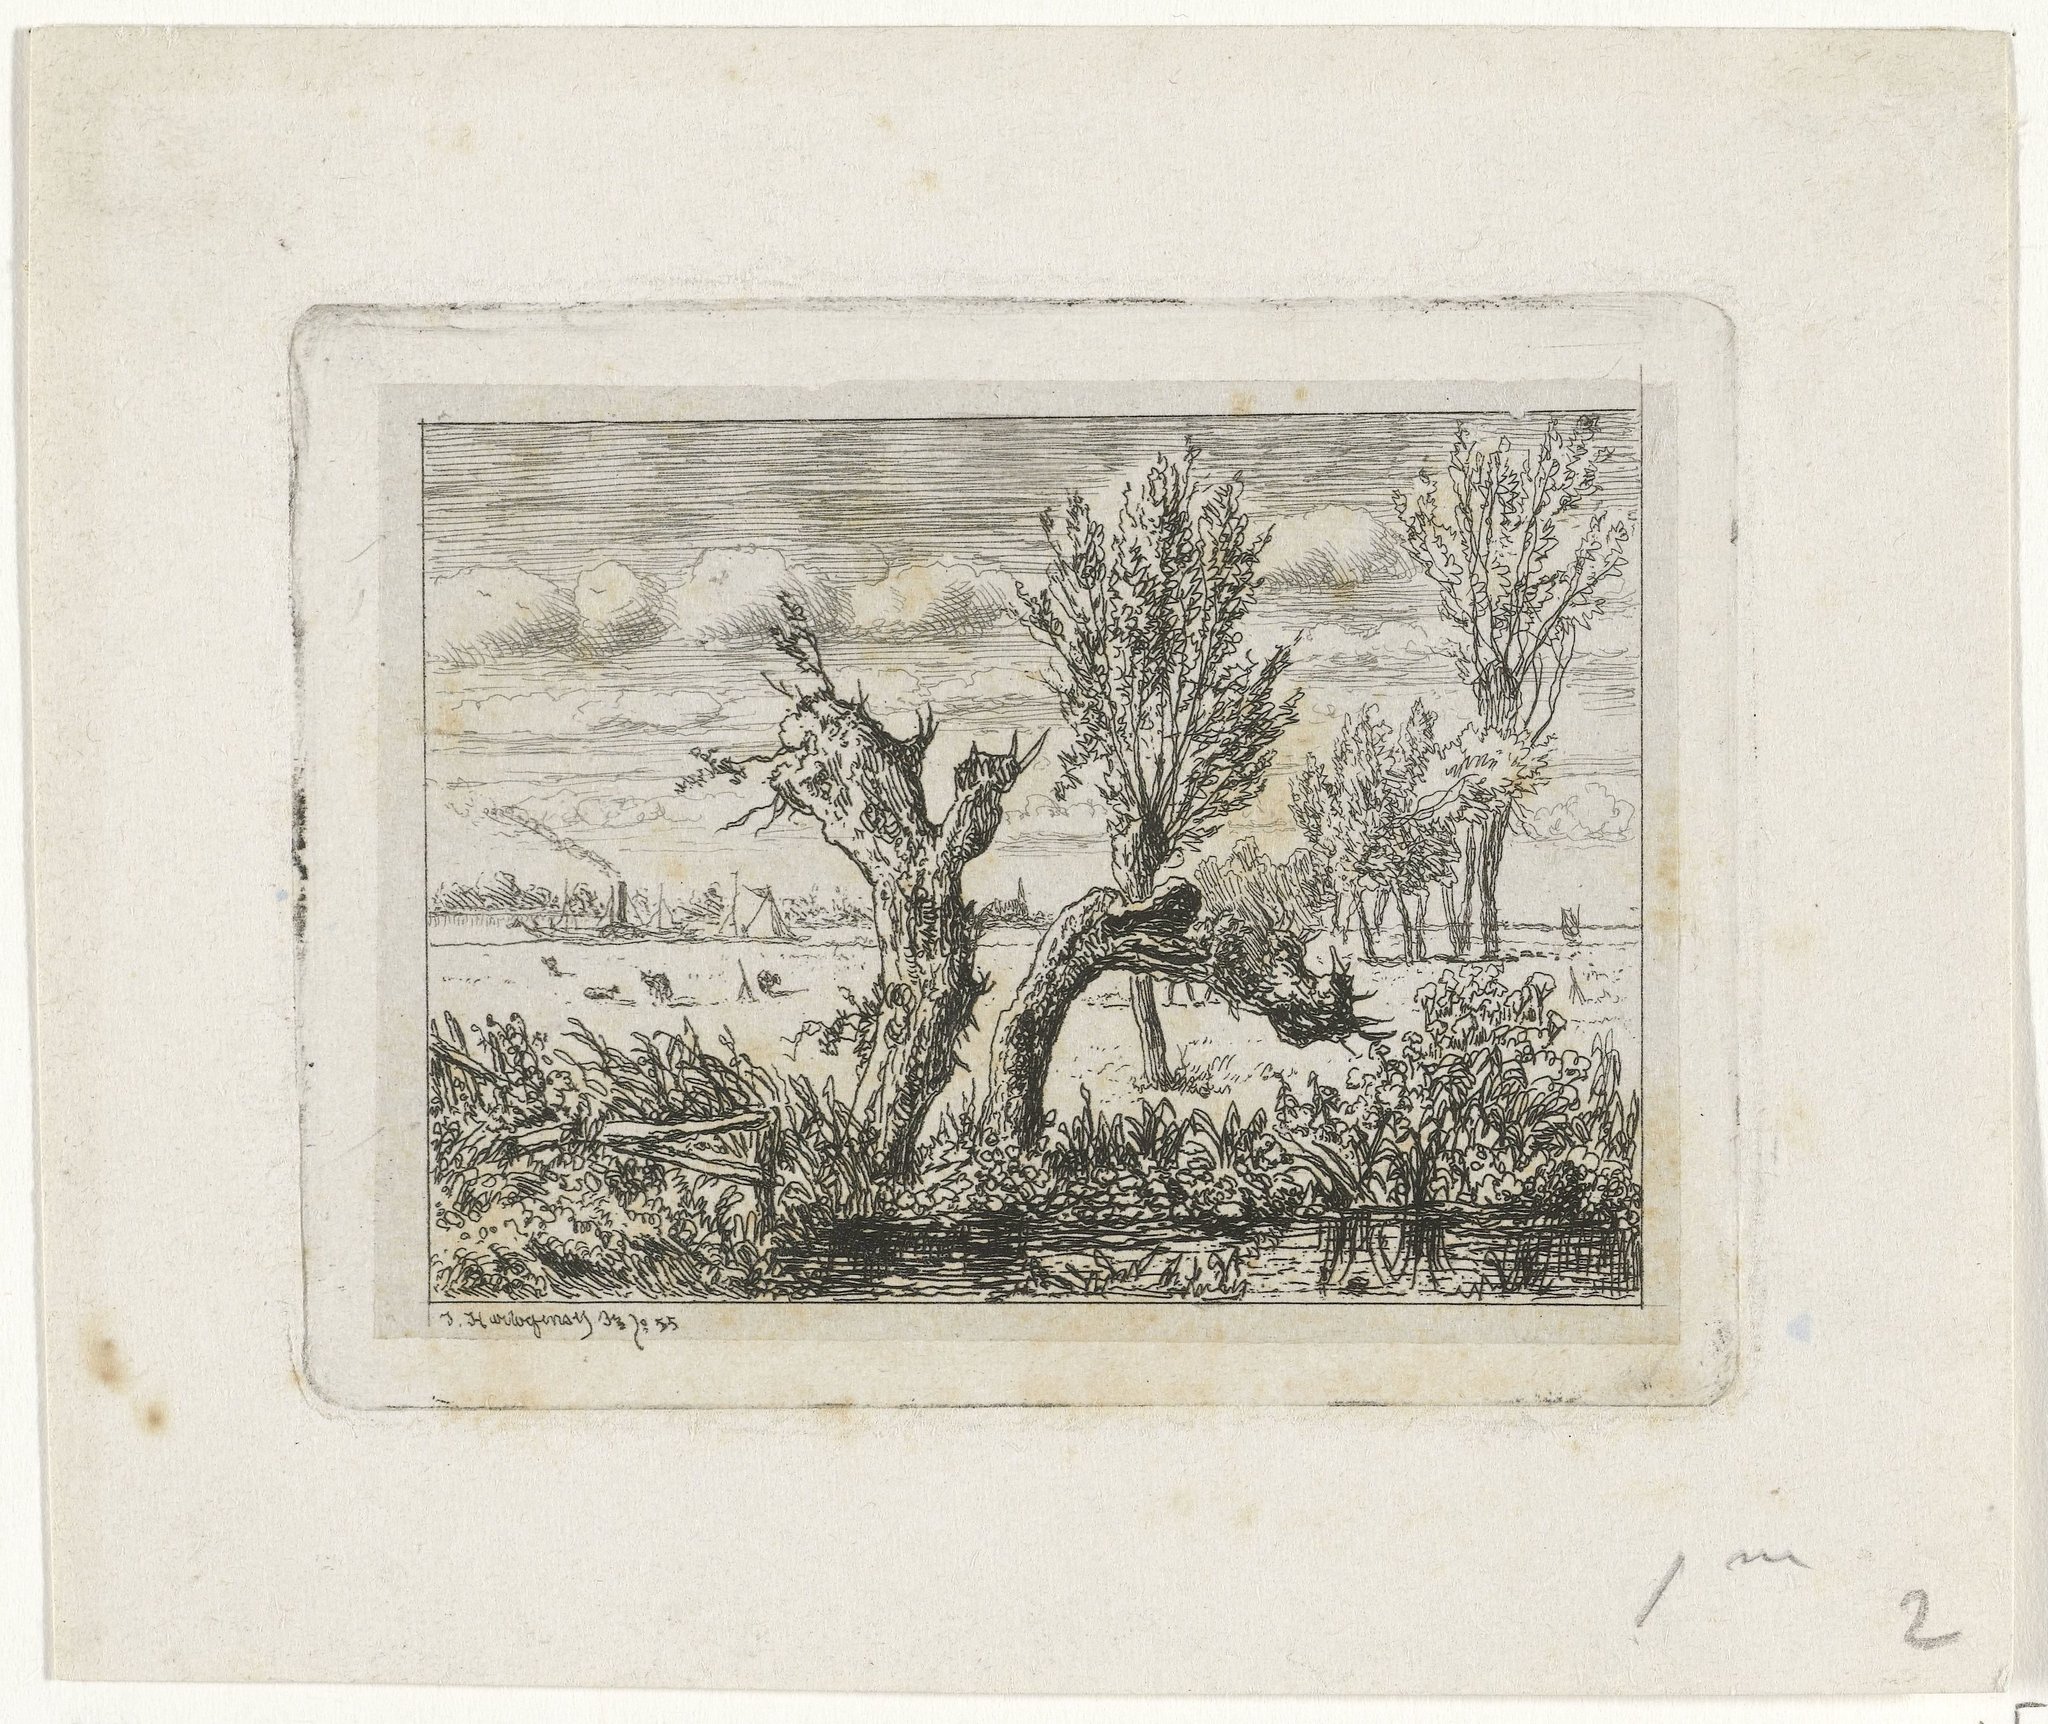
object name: print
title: Landschap met knotwilgen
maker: joseph hartogensis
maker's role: painter, print maker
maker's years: 1822-1865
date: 1855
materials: paper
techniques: etching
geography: the hague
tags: landscapes with waters, waterscapes, seascapes (in the temperate zone), trees: willow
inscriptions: collector's mark: Lugt 2228